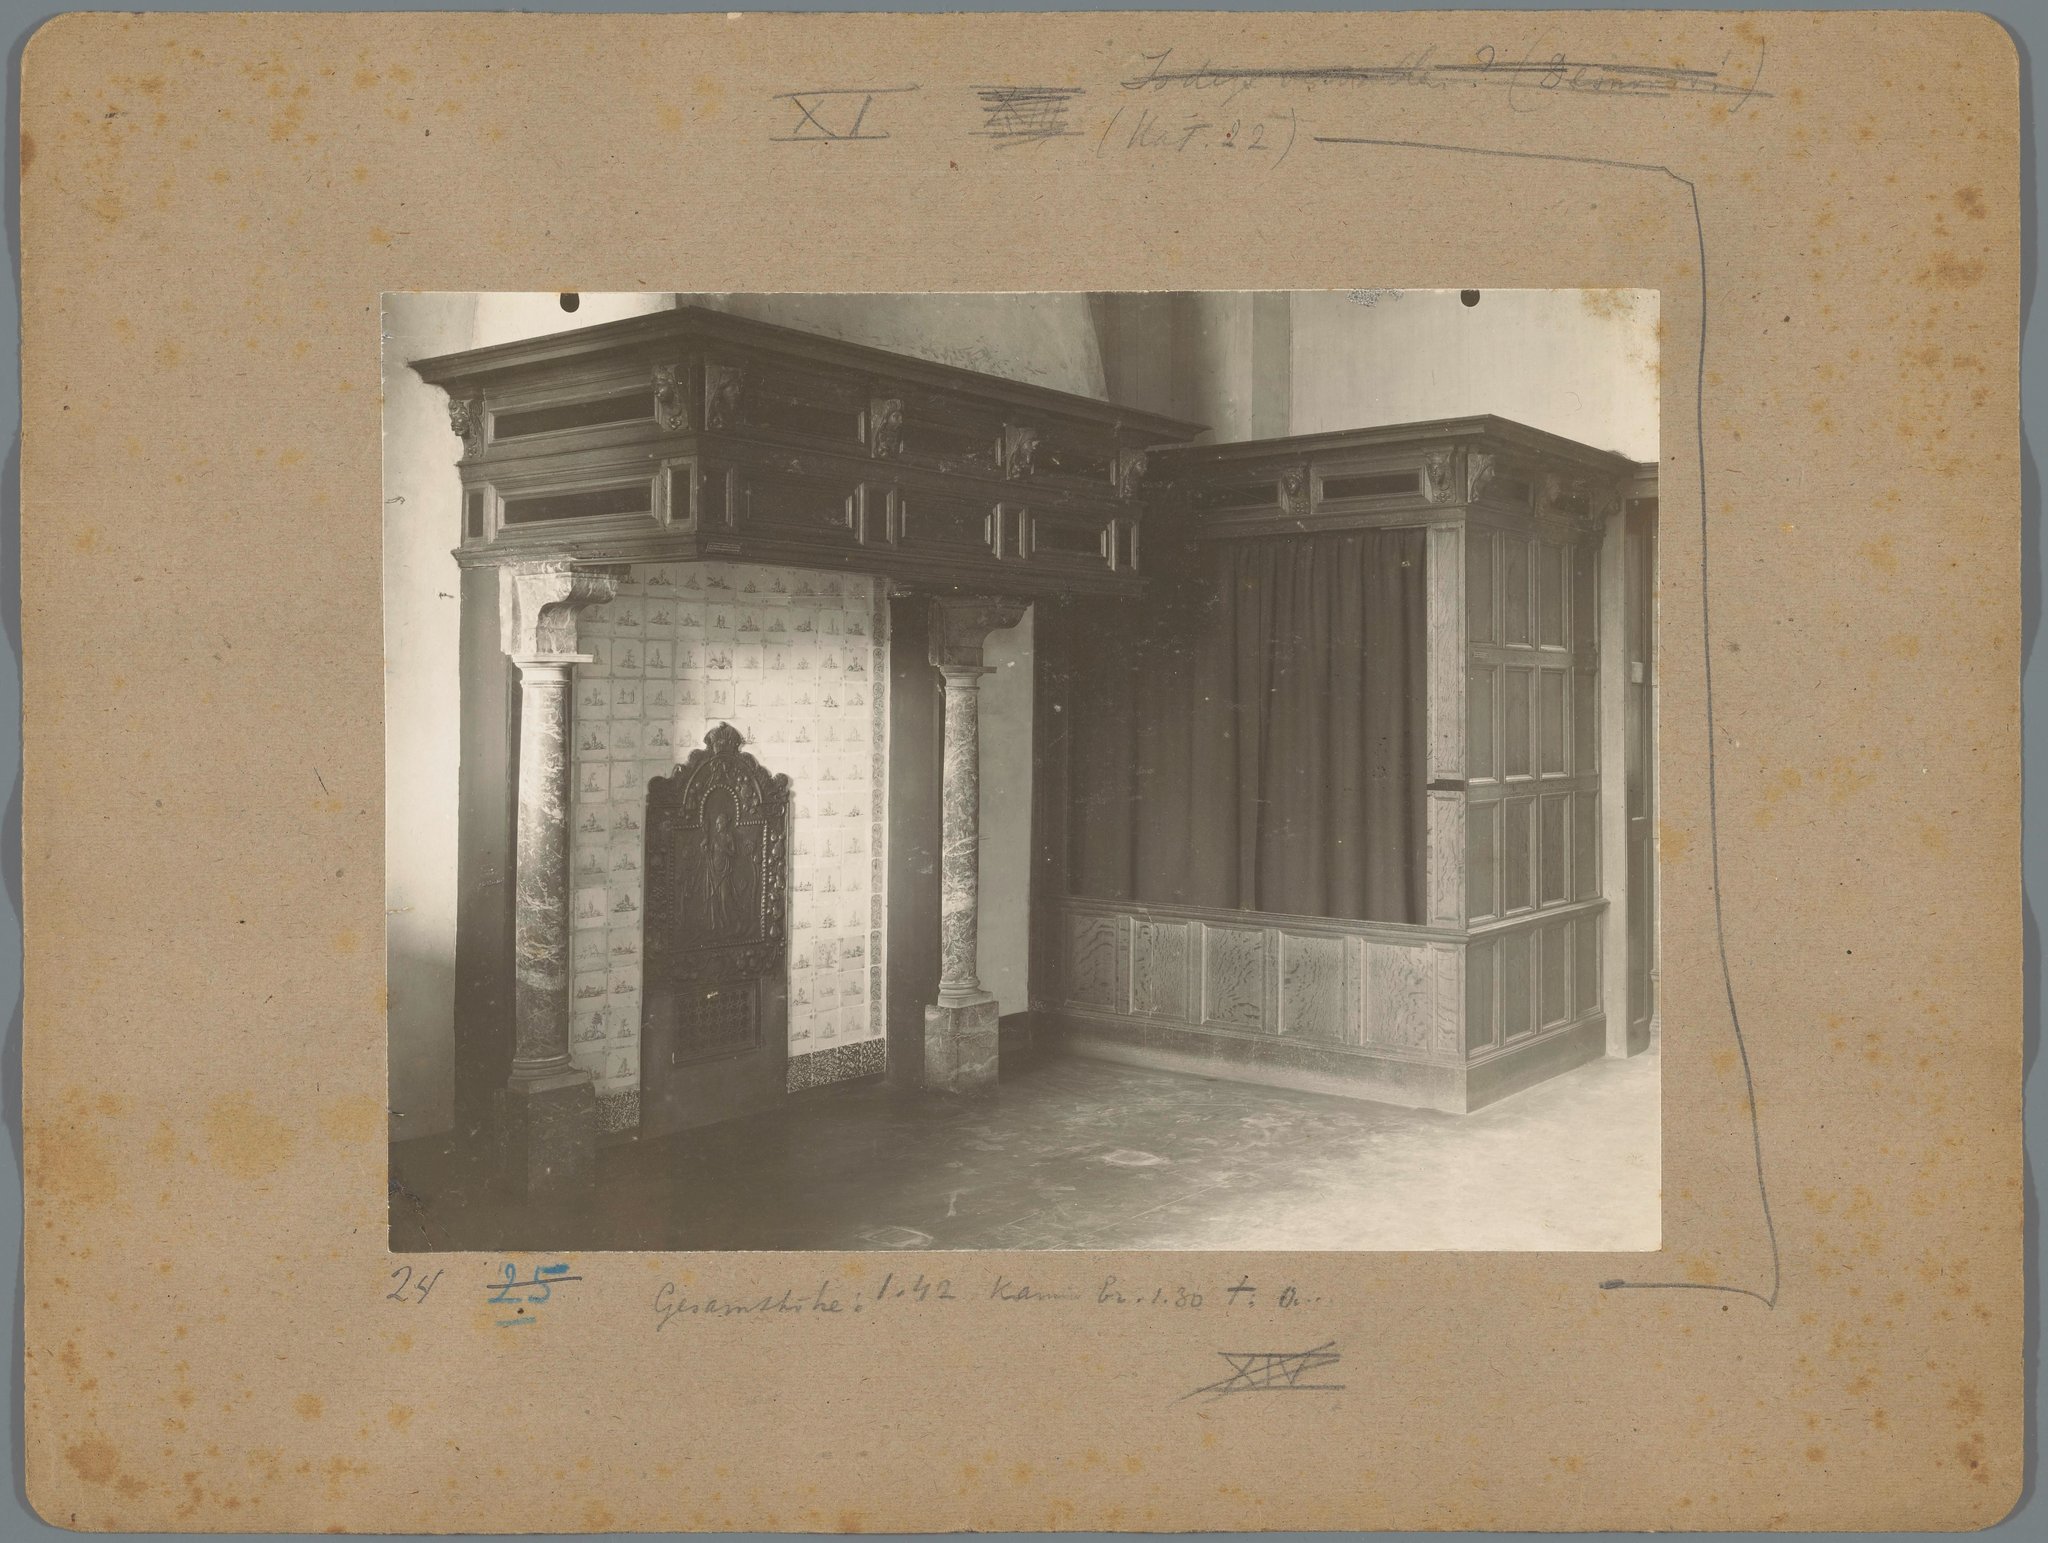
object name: photograph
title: Interieur van een kamer met een schouw en een bedstee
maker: Anonymous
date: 1875-1900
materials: cardboard, photographic support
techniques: gelatin silver print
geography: europe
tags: open hearth, fire-place, tiles, bricks ~ building material, built-in bedstead (dutch: 'bedstee'), europe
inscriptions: number: ‘(Kat 22)’, number: ‘24’, collector's mark: ‘INSTITUUT VOOR KUNST-NIJVERHEIDSONDERWIJS GABRIËL METSUSTRAAT No. 16 AMSTERDAM’, collector's mark: ‘KUNSTNIJVERHEIDSCHOOL QUELLINUS AMSTERDAM FRANS HALSSTRAAT 14.’, number: ‘XI’